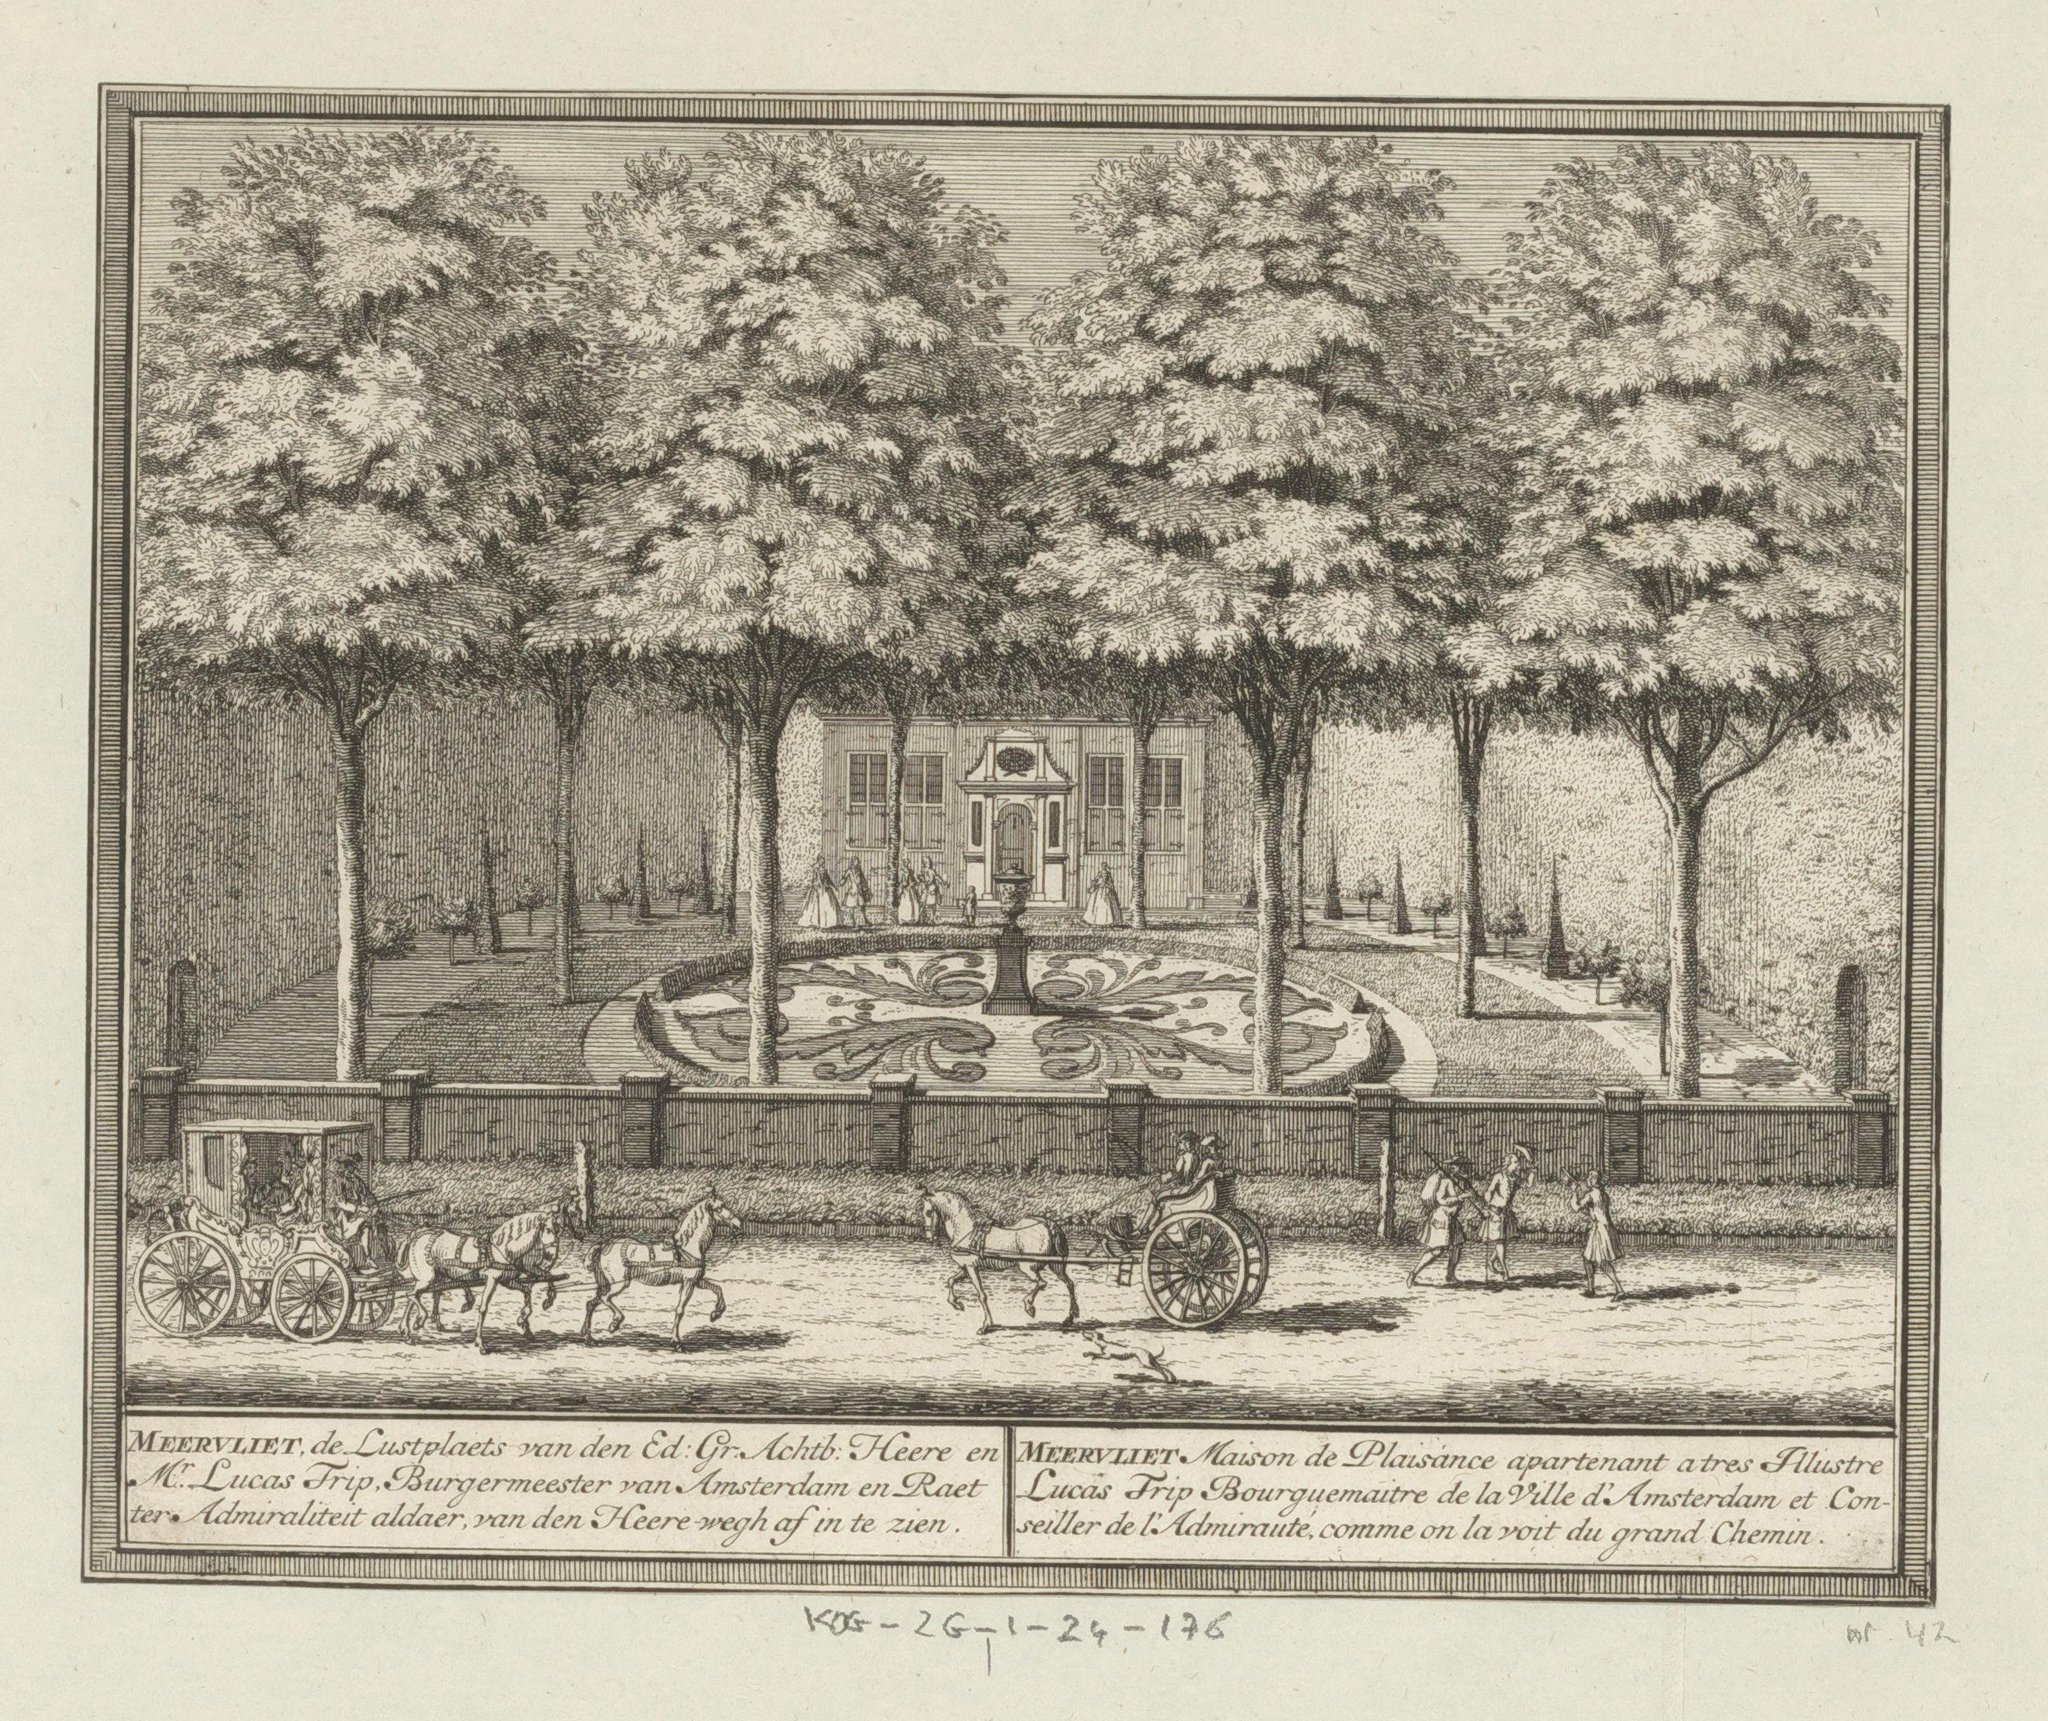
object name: print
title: Meervliet, de Lustplaets van den Ed. Gr. Achtb. Heere en Mr. Lucas Trip (...) / Meervliet Maison de Plaisance apartenant a tres Illustre Lucas Trip (...)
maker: hendrik de leth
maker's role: draughtsman, print maker, publisher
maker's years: 1703-1766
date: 1729-1732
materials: paper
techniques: engraving, etching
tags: barrier, french or architectonic garden; formal garden, country-house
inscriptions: collector's mark: Lugt 1641, stamp, stamp, stamp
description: Prent mogelijk uit: Brouërius van Nidek, Matthaeus. Het zegepralend Kennemerland, vertoond in 100 heerlyke gezichten. Amsterdam: Jan Roman, s.a. Of uit: Brouërius van Nidek, Matthaeus. Het zegepralend Kennemerland, vertoond in veele heerlyke gezichten. Amsterdam: Andries en Hendrik de Leth, s.a [1729-1732]. Of uit: Brouërius van Nidek, Matthaeus. Het zegepralend Kennemerland, vertoond in veele heerlyke gezichten. Amsterdam: Jan Roman, s.a.